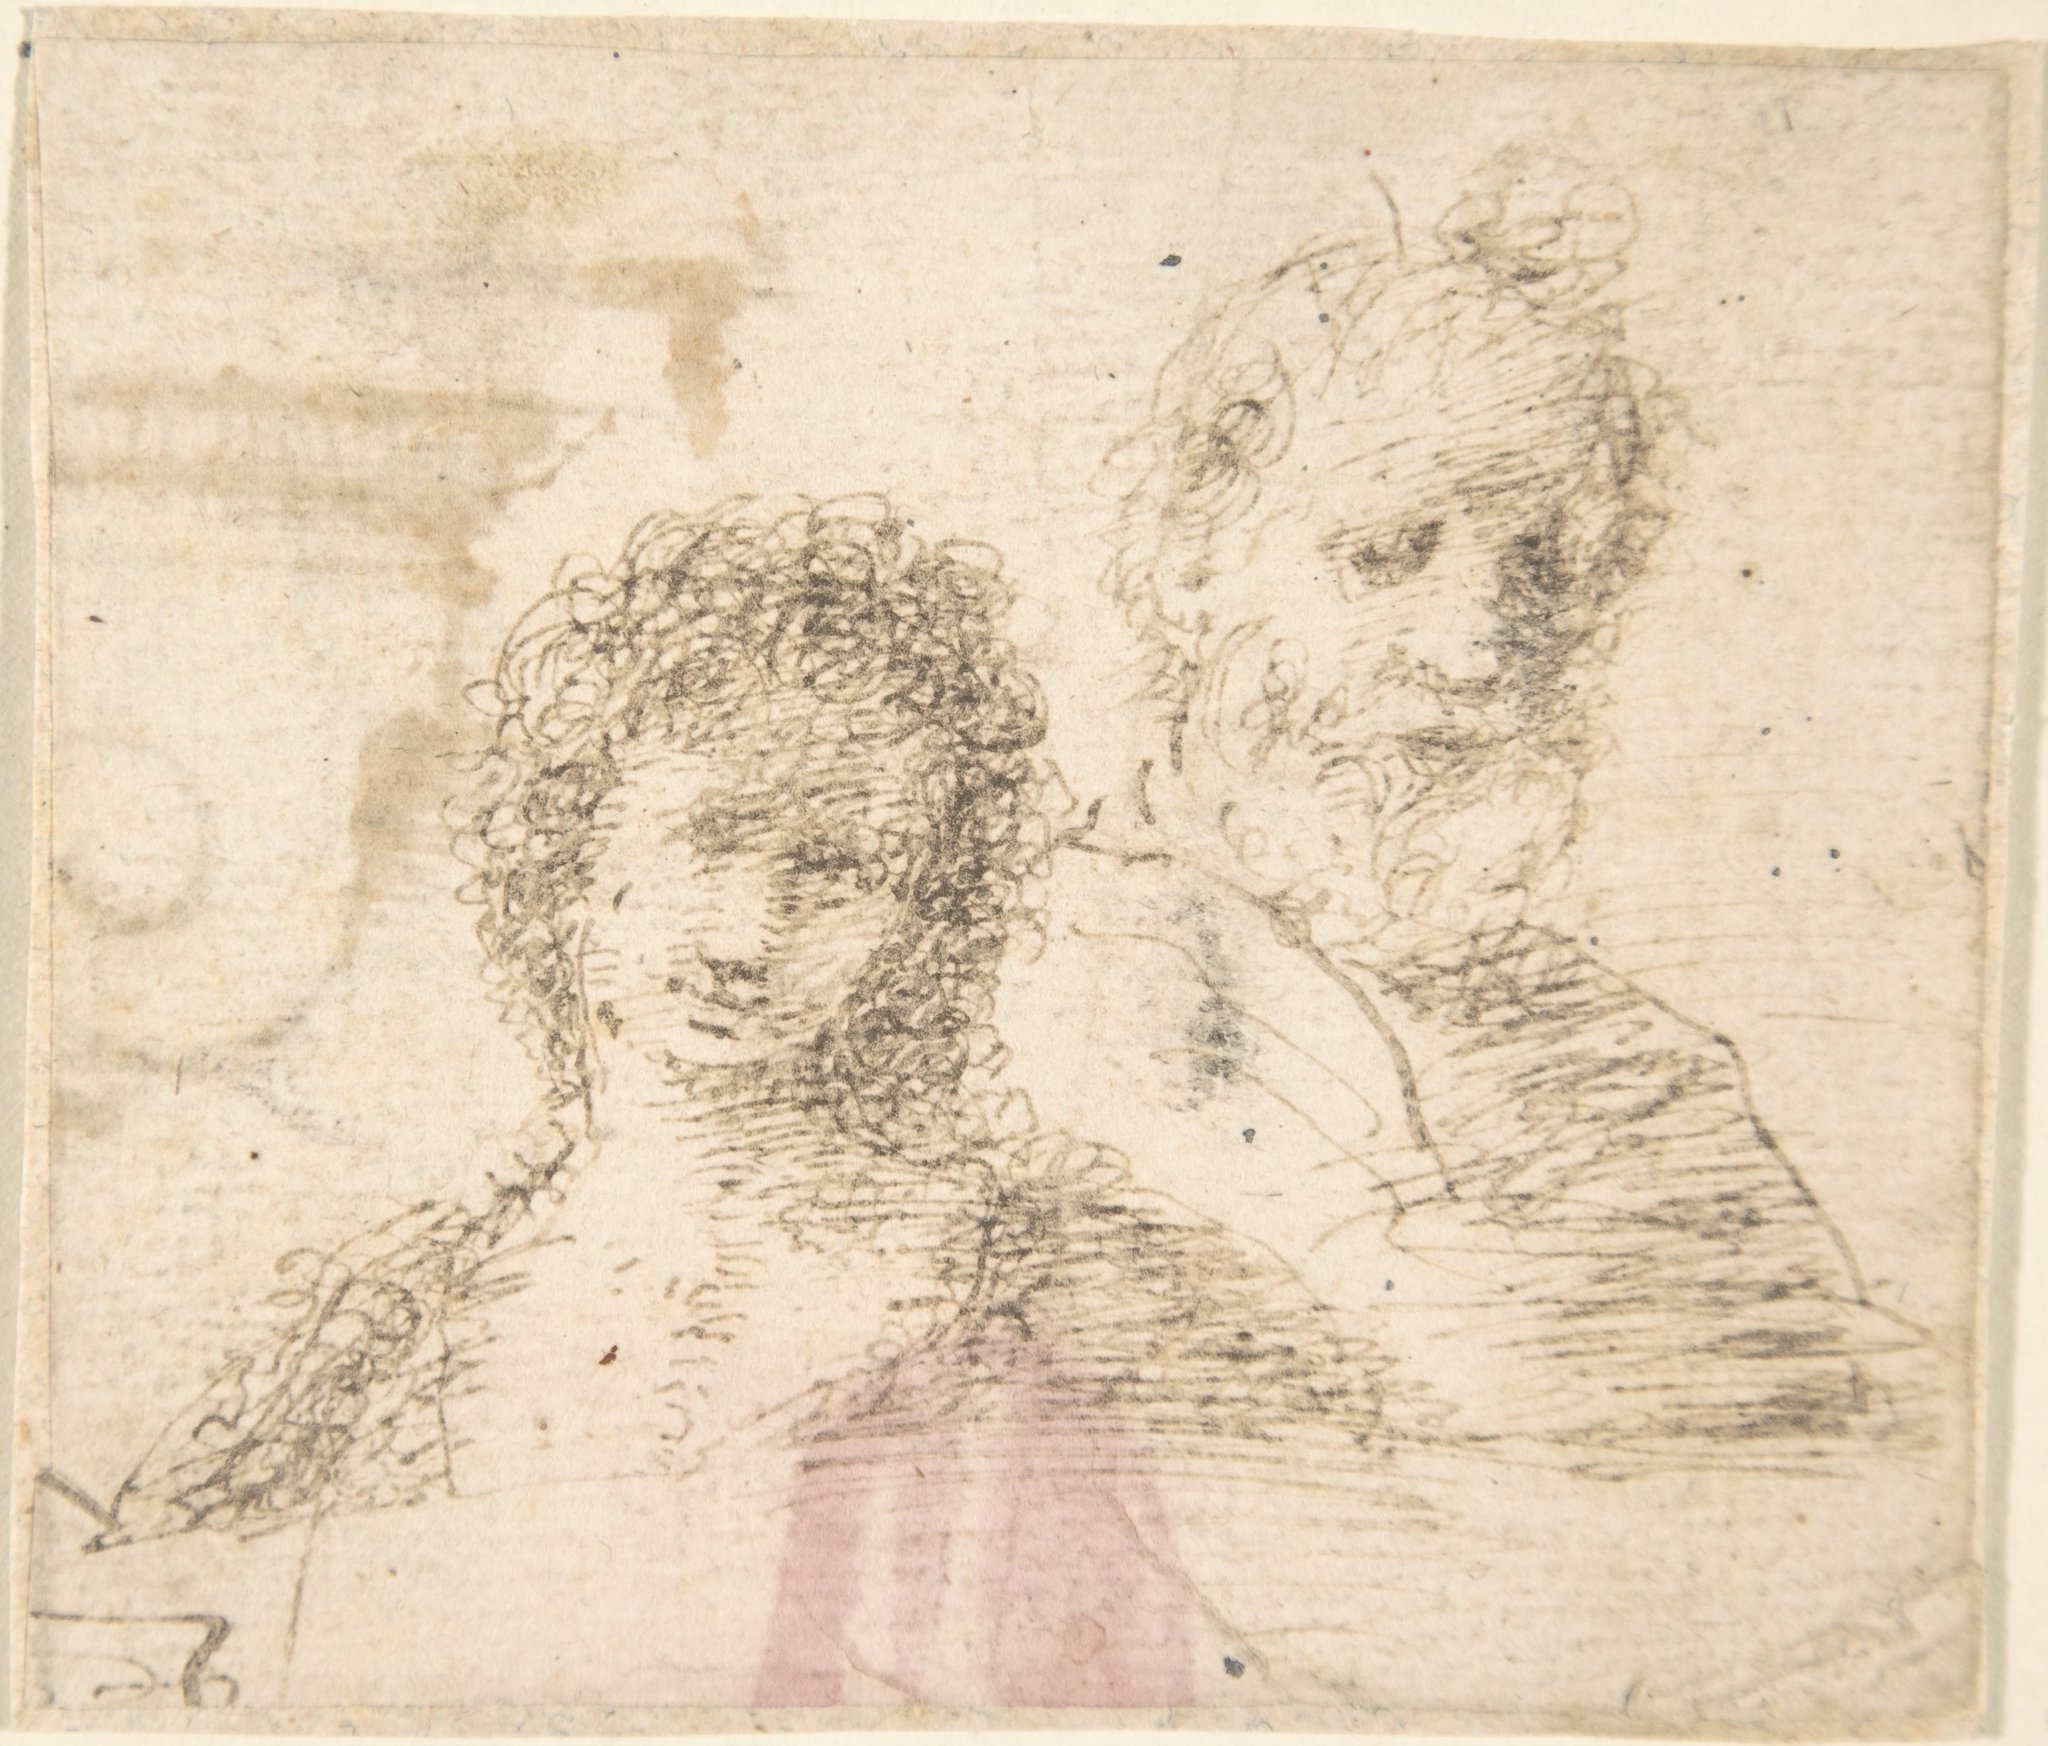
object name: drawing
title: Busts of a Young Woman and an Old Bearded Man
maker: anonymous, spanish, school of seville, 17th century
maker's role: artist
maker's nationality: spanish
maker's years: 1600-1700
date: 1601-1700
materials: ink, paper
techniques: pen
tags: men,portraits,women